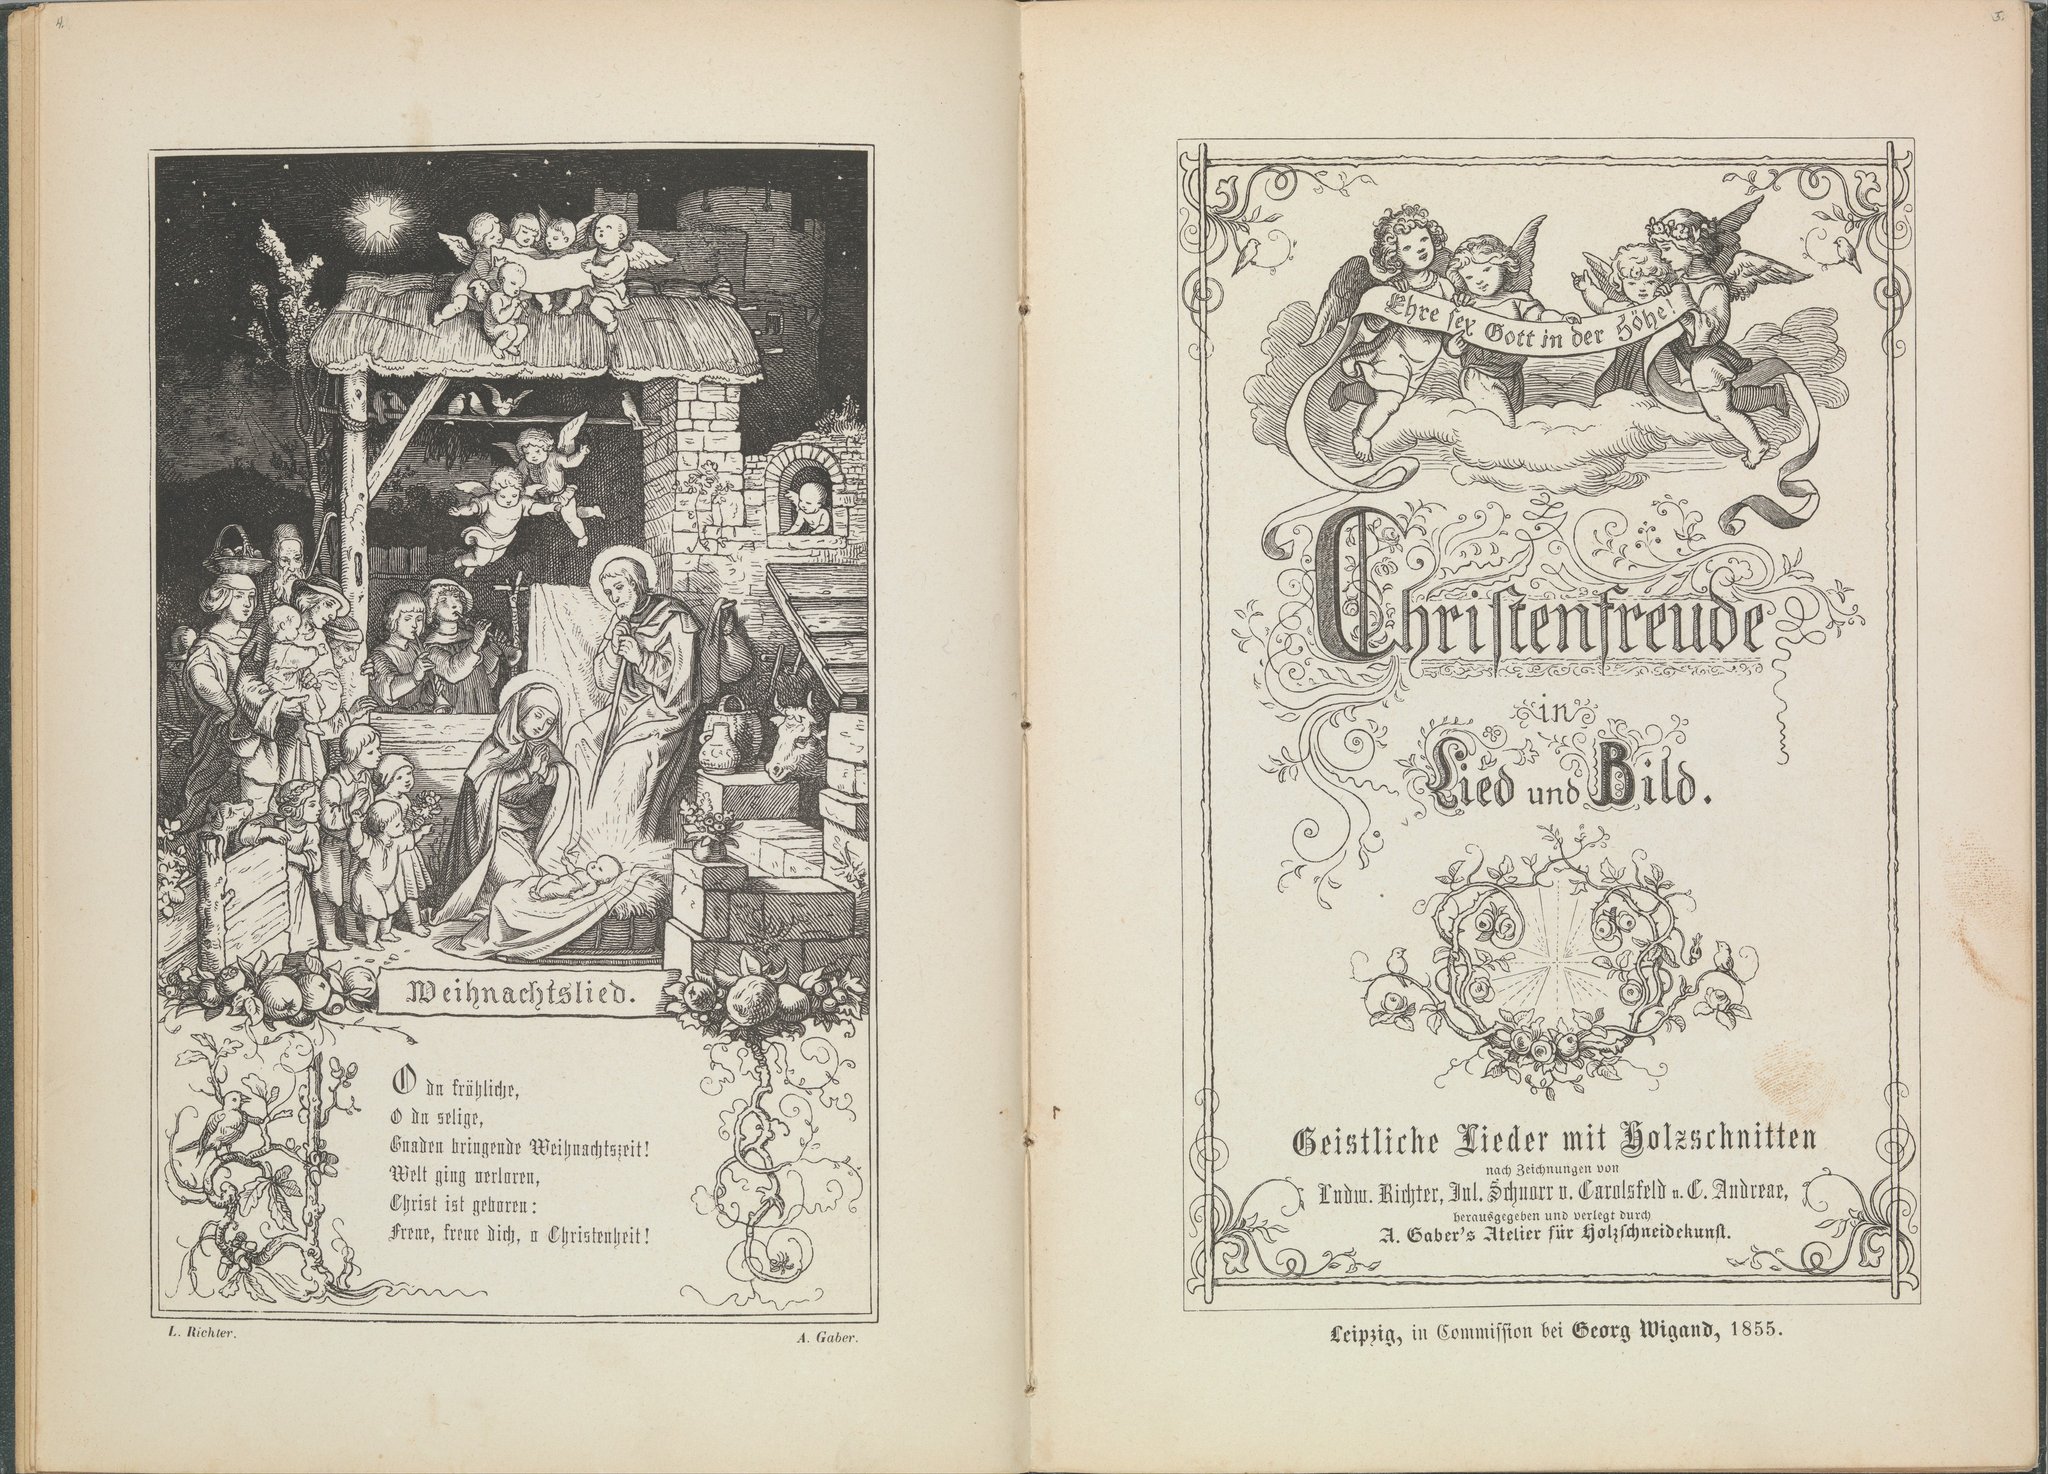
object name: book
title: Christenfreude in Lied und Bild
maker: adrian ludwig richter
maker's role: artist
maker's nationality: german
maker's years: 1803-1884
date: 1855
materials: wood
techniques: engraving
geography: leipzig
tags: angels,madonna and child